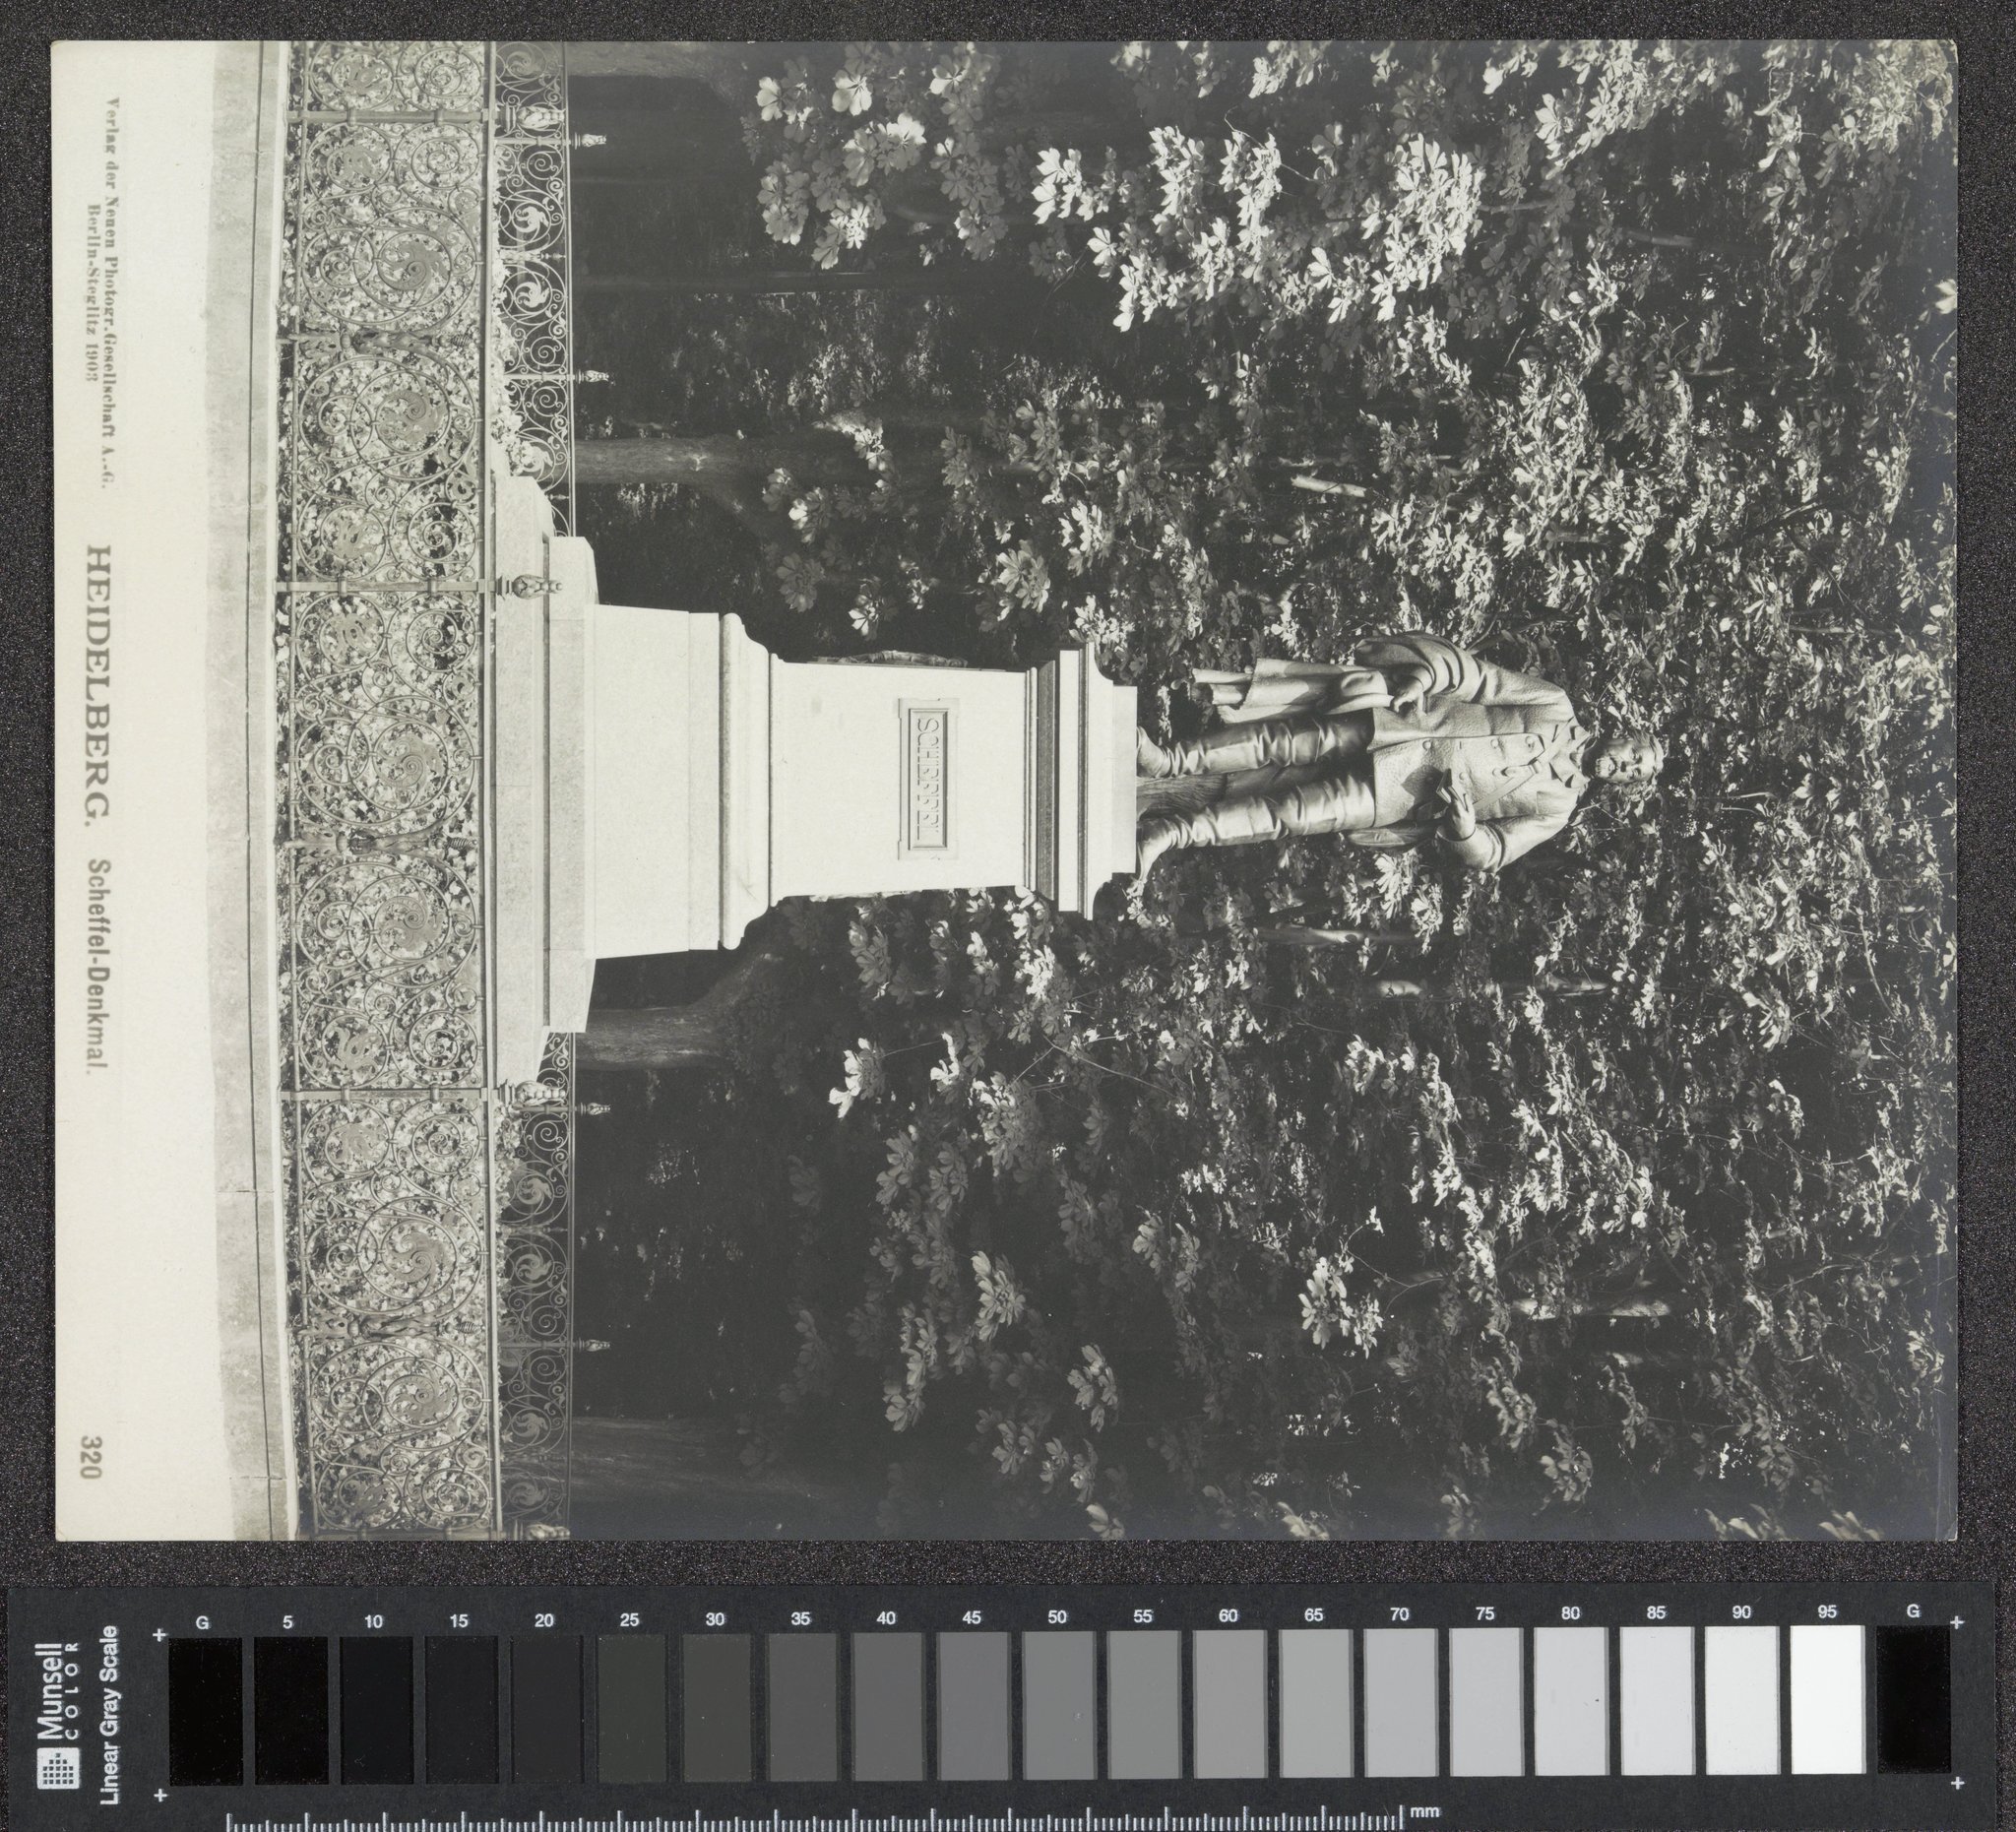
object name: photograph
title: Standbeeld van de schrijver Joseph Victor von Scheffel in Heidelberg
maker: Anonymous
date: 1903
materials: photographic support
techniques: gelatin silver print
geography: heidelberg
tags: monument, statue, prospect of city, town panorama, silhouette of city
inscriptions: number: ‘320’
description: Onderdeel van Fotoalbum met opnames van Heidelberg en Schloss Heidelberg.